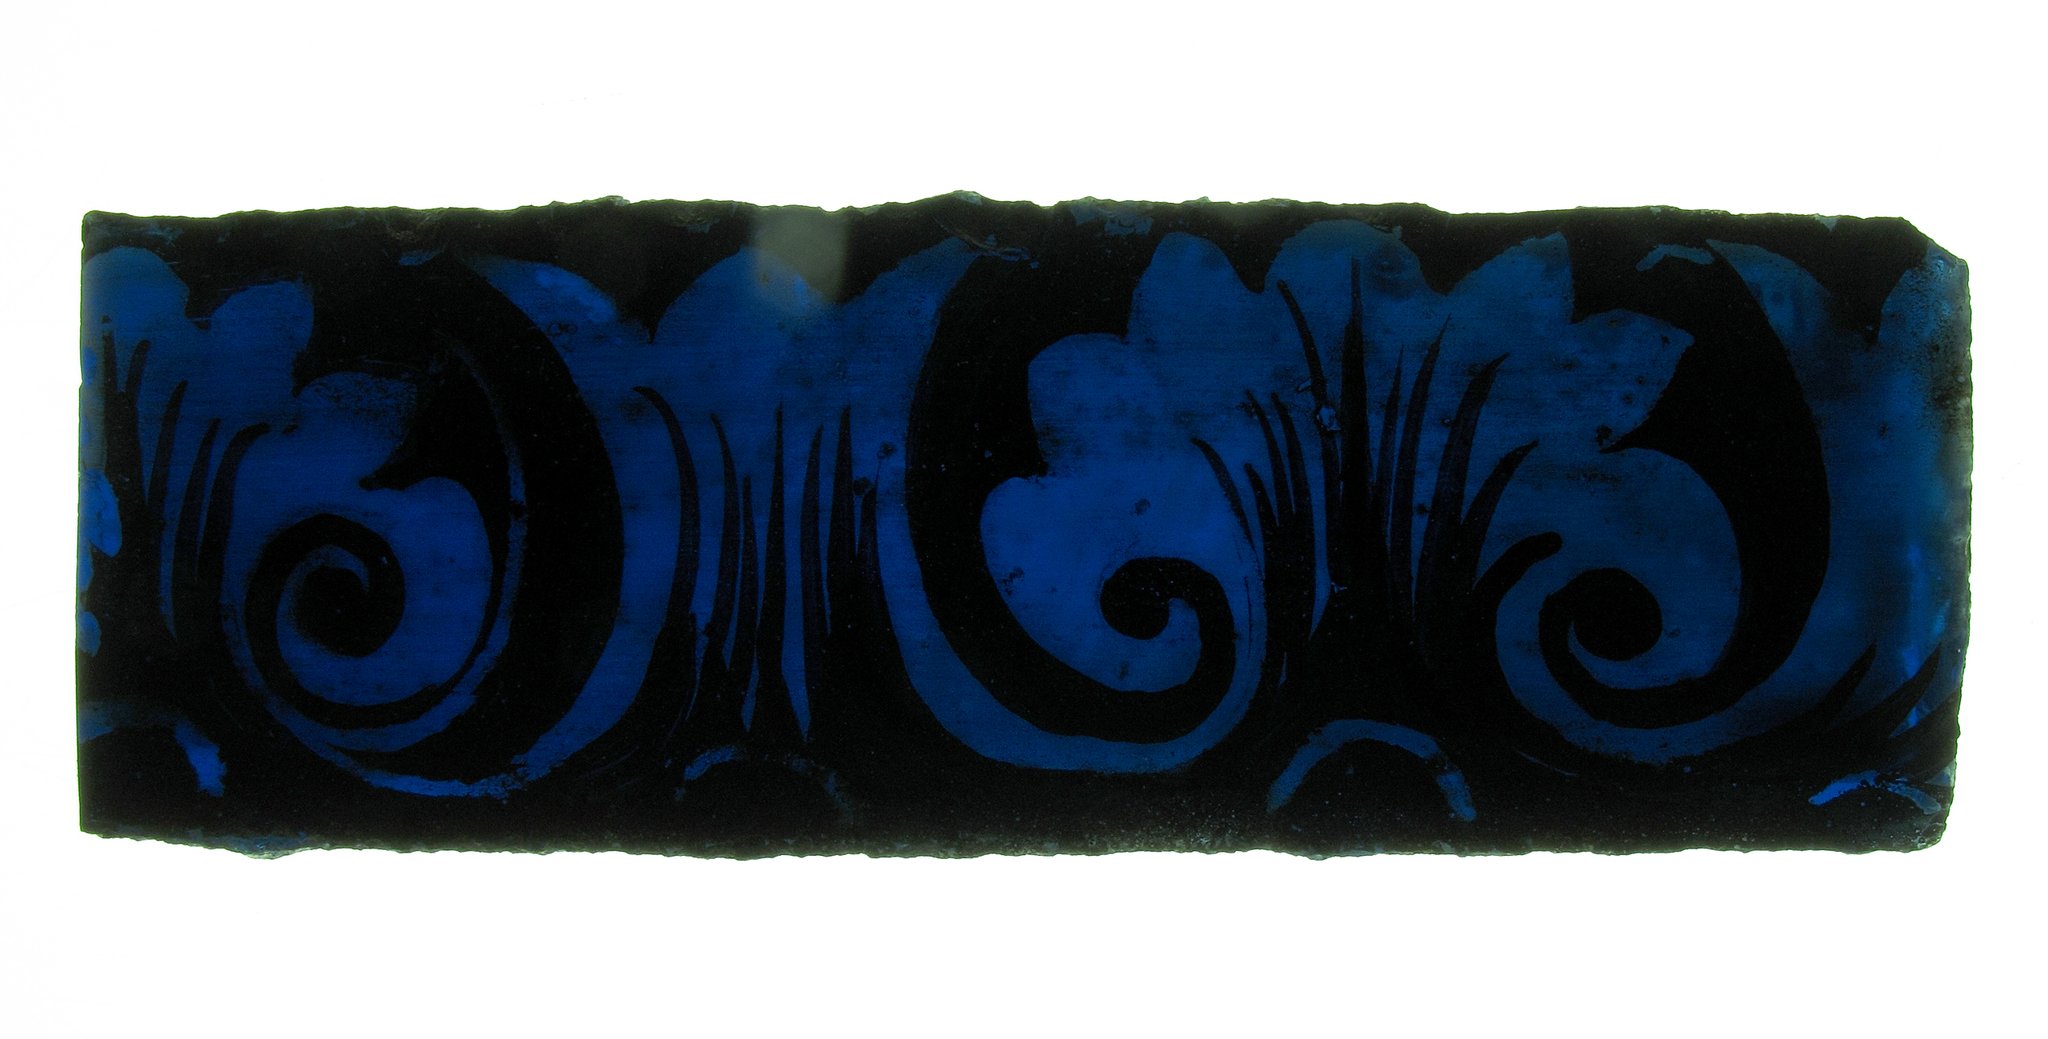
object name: fragment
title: Glass Fragment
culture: european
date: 1801-1900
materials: glass, metal